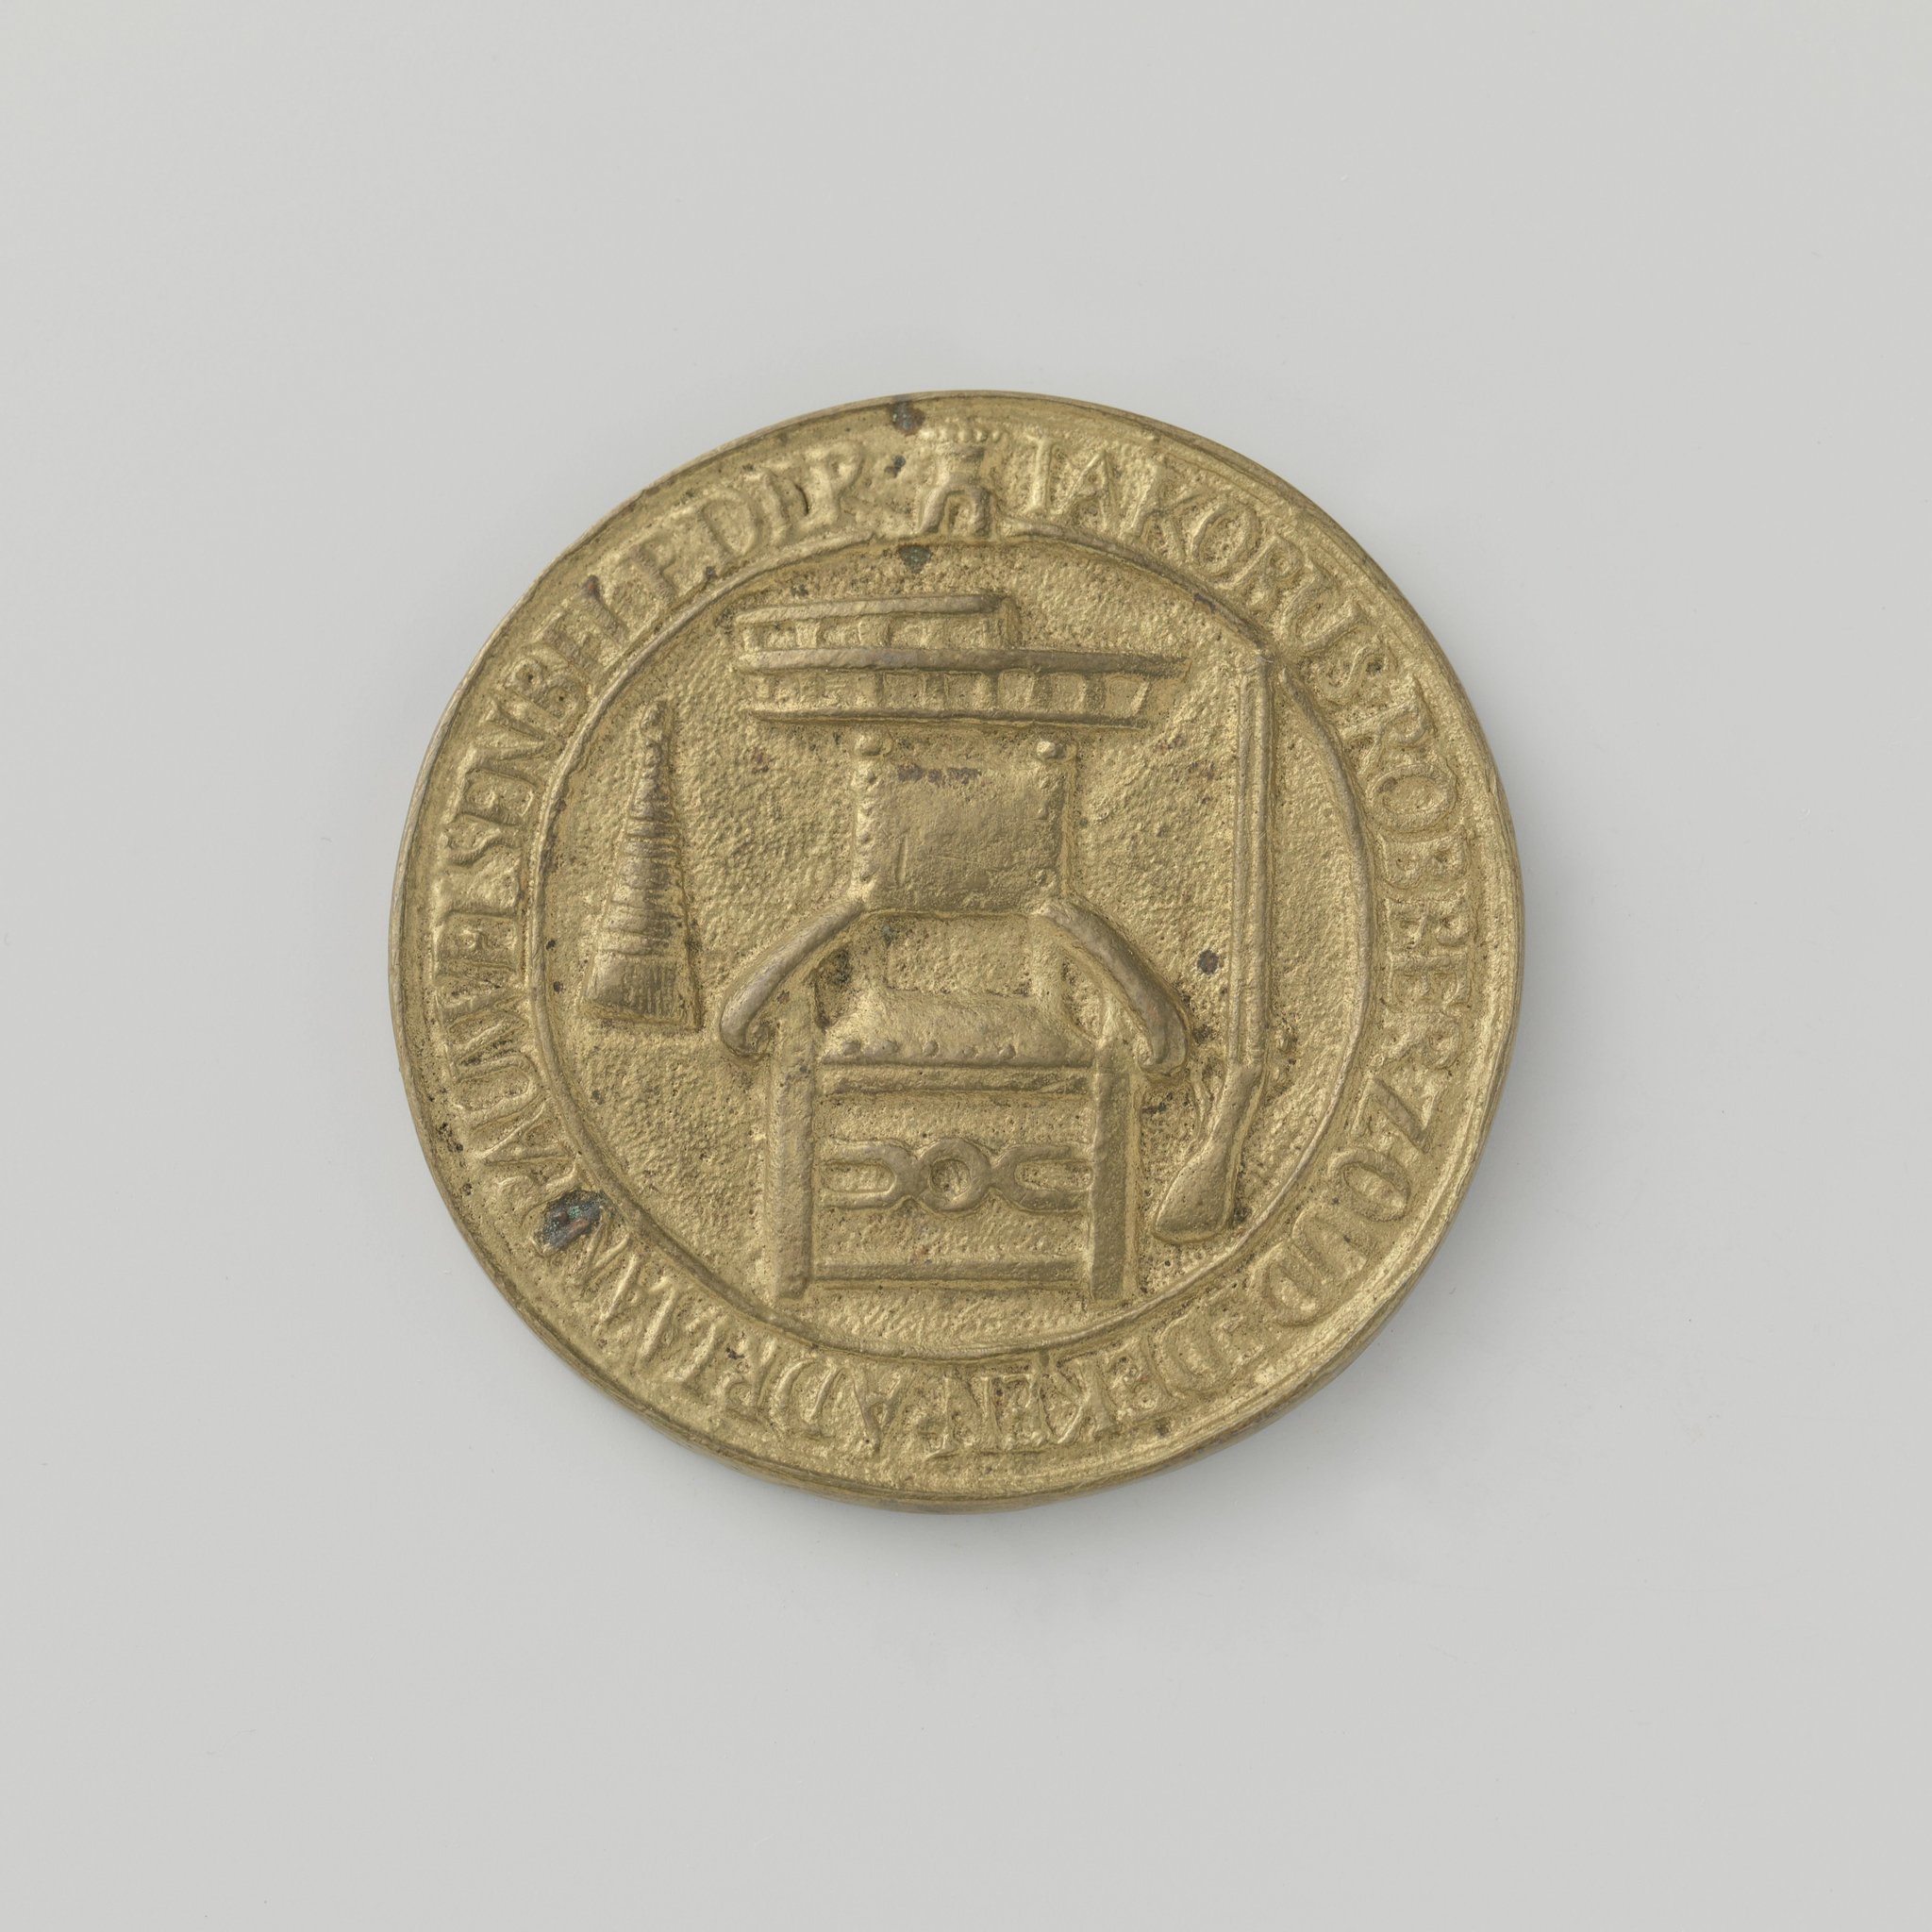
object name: medal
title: Turners’ Guild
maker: willem du pre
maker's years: 1687-1722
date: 1709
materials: brass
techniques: casting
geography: middelburg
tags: middelburg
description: Messing penning. Voorzijde: stoel met gedraaide stijlen en poten tussen jaartal, staande op kist met opschrift binnen omschrift. Keerzijde: leunstoel tussen borstel en geweer onder ladder binnen omschrift.